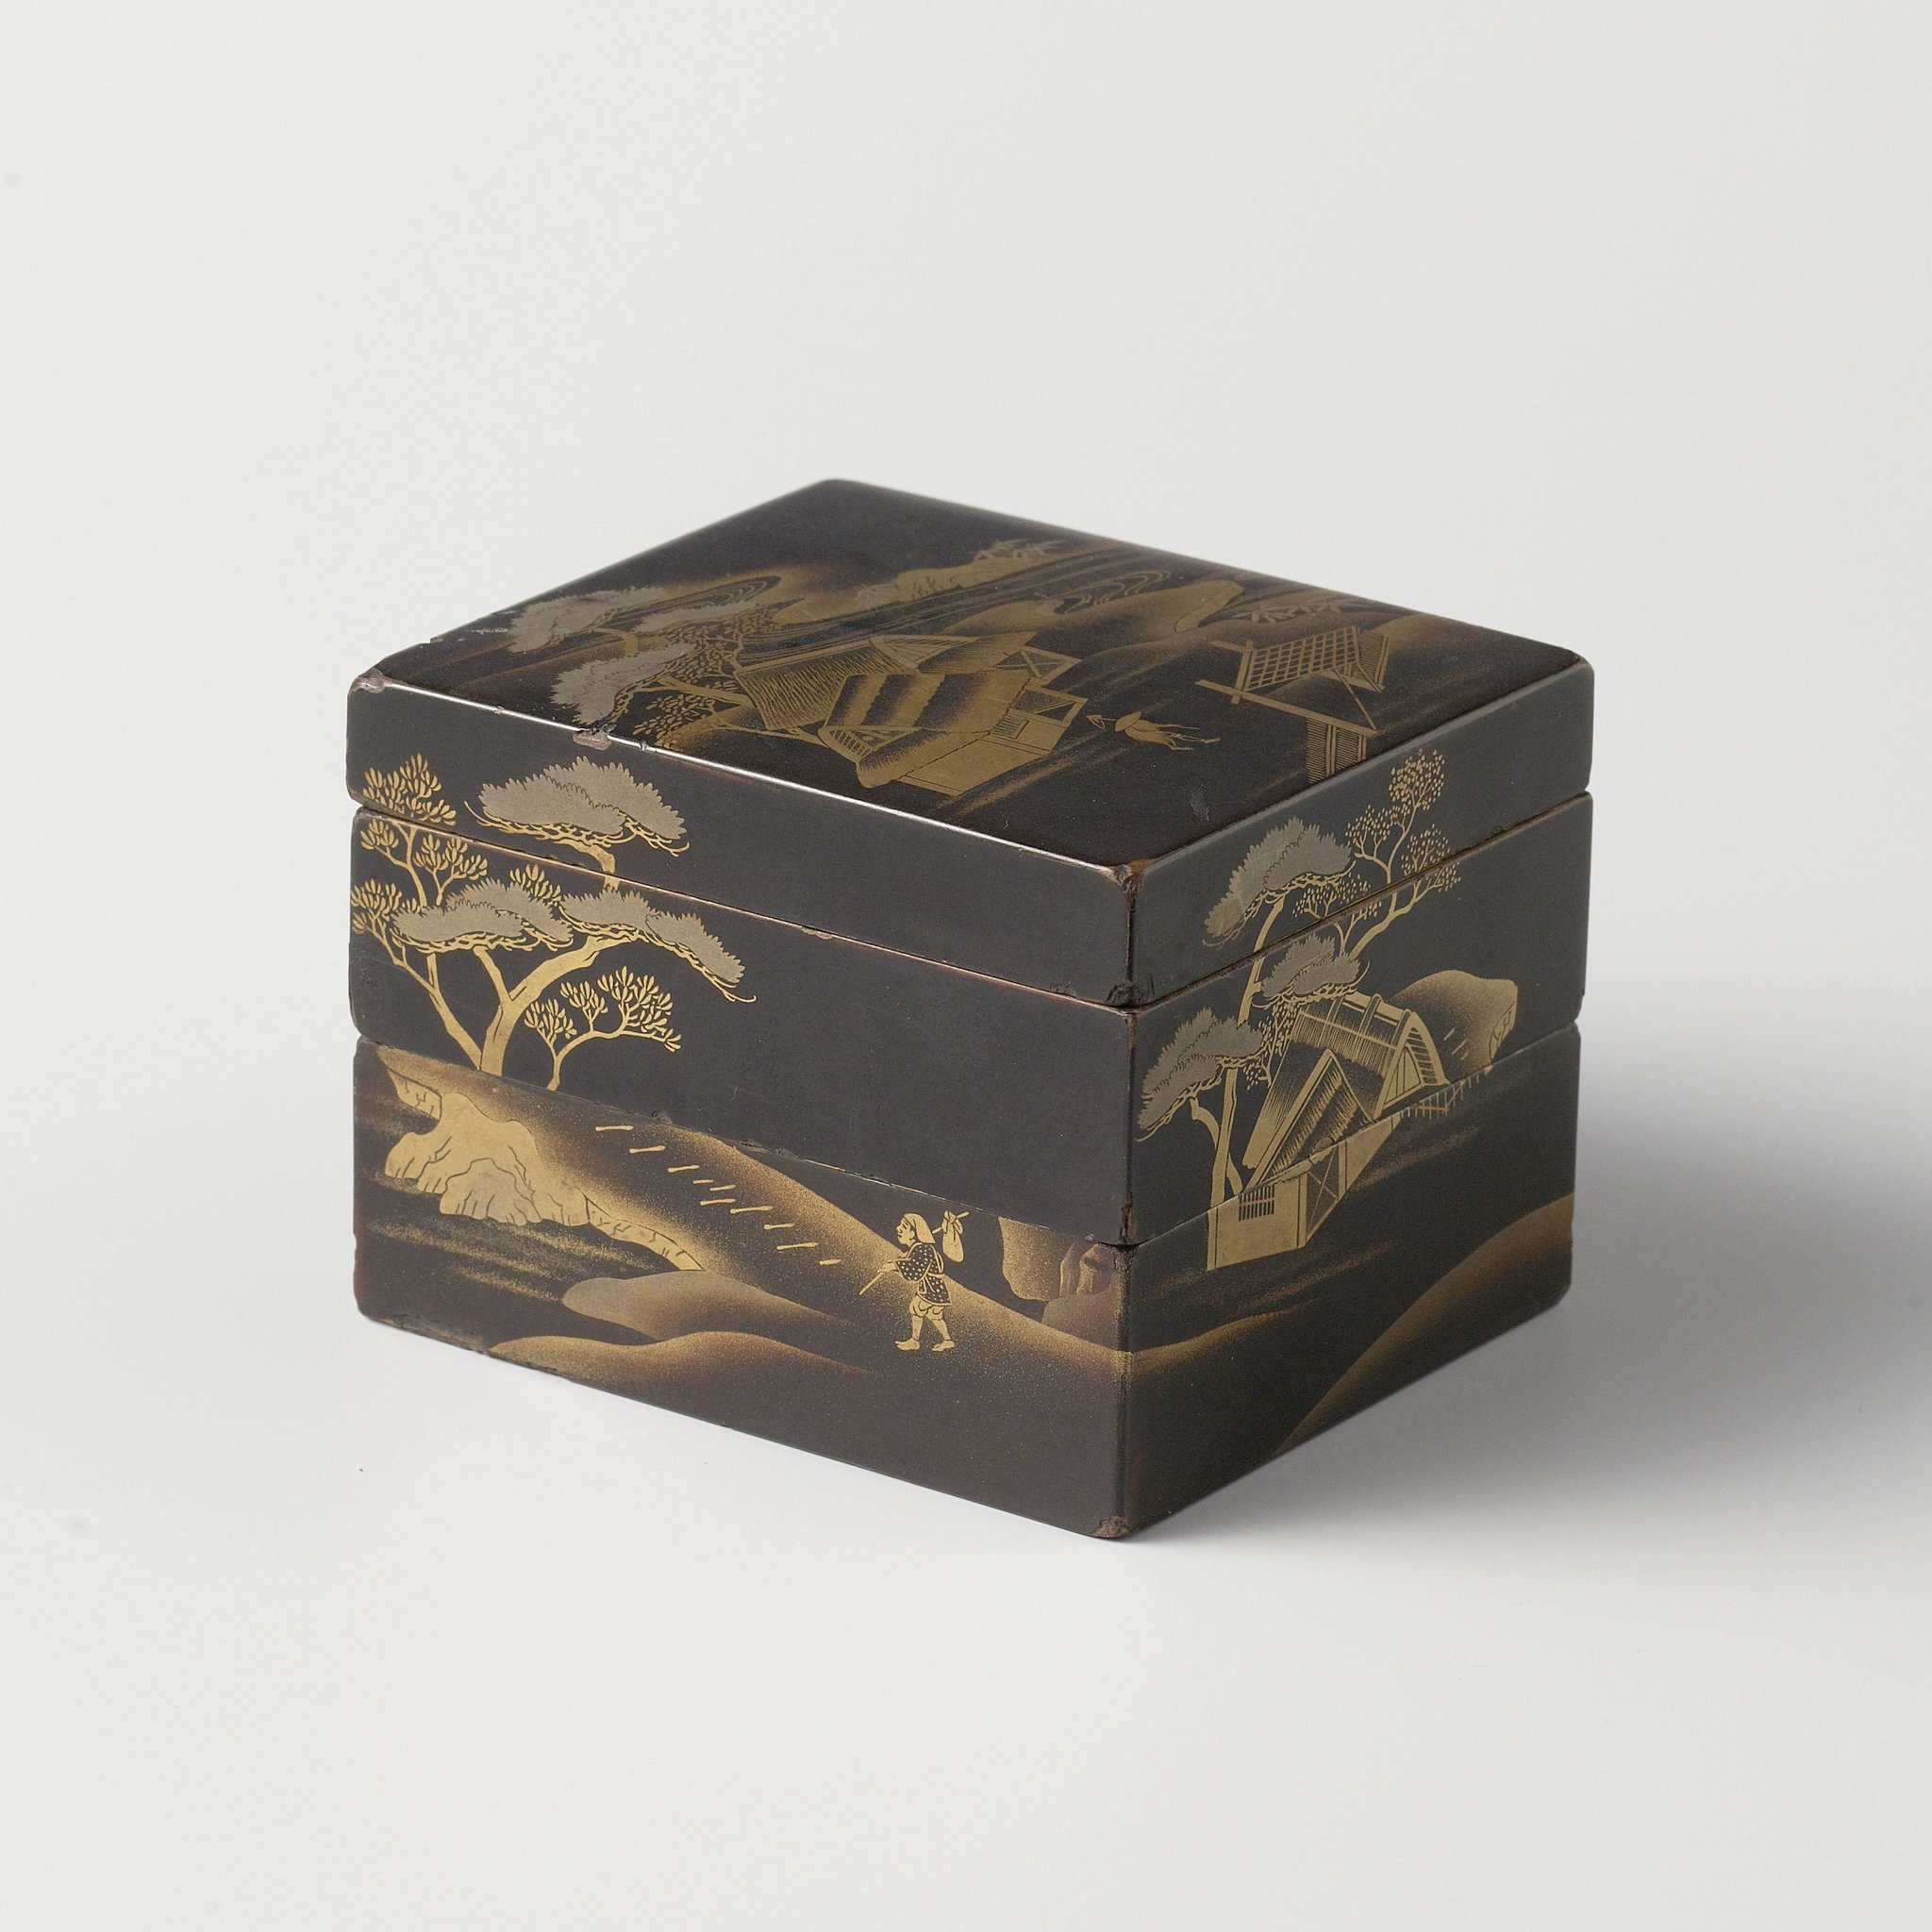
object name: box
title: Doos, zwarte lak, met vergulde landschappen en gebouwen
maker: Anonymous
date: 1700-1800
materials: gold, lacquer, wood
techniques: lacquer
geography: japan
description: Doos, bestaande uit twee (oorspronkelijk drie) ineensluitende bakjes en deksel. Van buiten zwarte lak met waterlandlandschappen, gebouwen en enkele figuren in goud-makie. Van binnen nashiji.